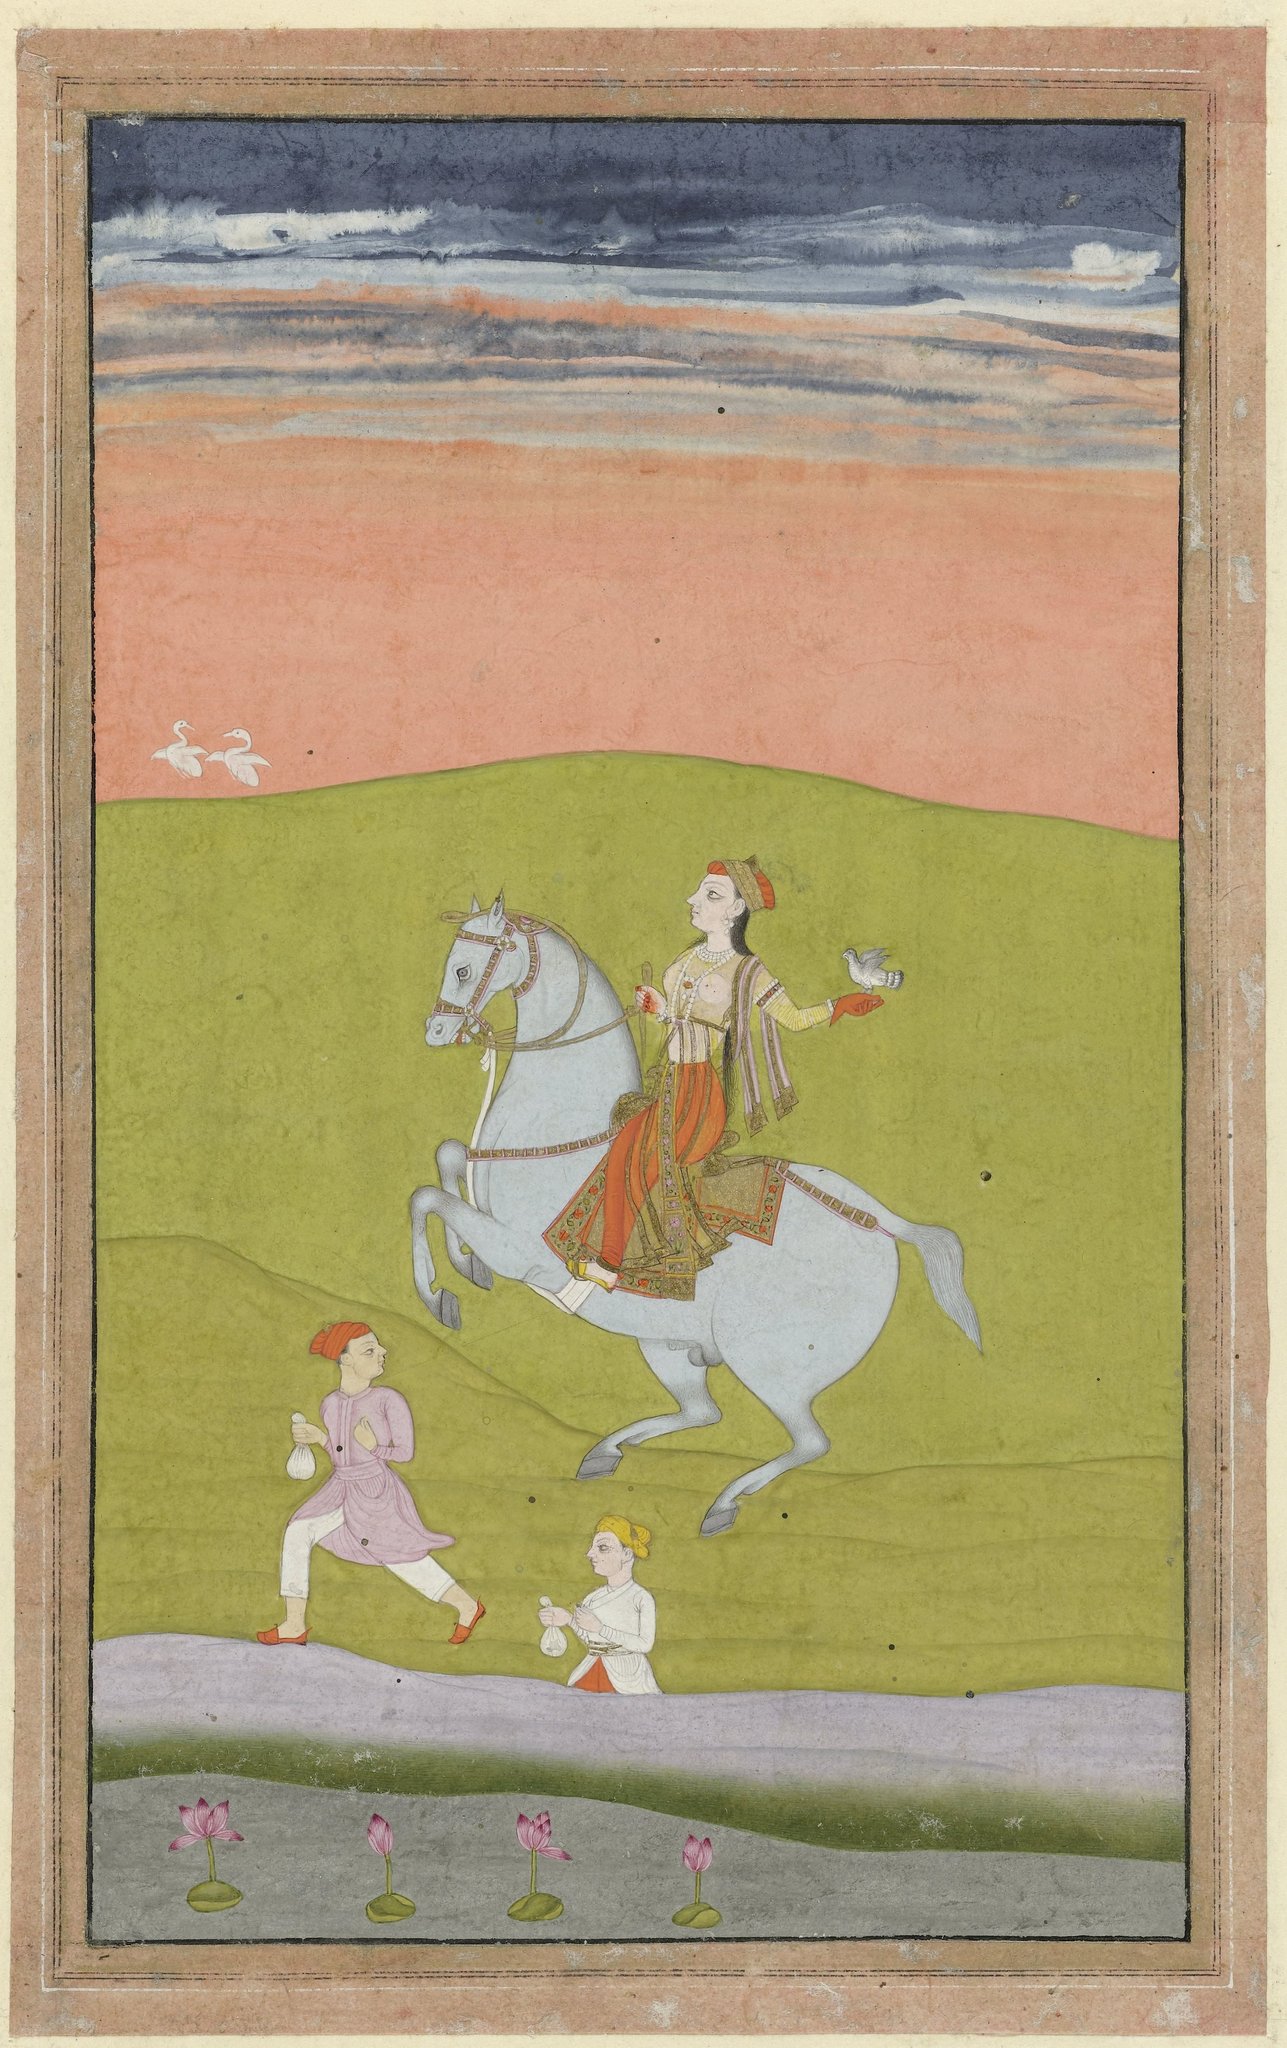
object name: indian miniature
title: Queen Chand Bibi on horseback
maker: Anonymous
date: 1780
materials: paper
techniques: brush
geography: deccan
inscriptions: inscription: ‘Spencer Churchill coll.’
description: Chand Bibi of Ahmadnagar (16th century) is one of the few queens who successfully wielded power. She protected her kingdom from the Mughal imperial armies. There are no surviving pictures of her made during her lifetime, but the valiant warrior queen became a favourite subject in the 18th century. She is almost always depicted hawking and never while defending the city of Ahmadnagar, her main feat of arms.